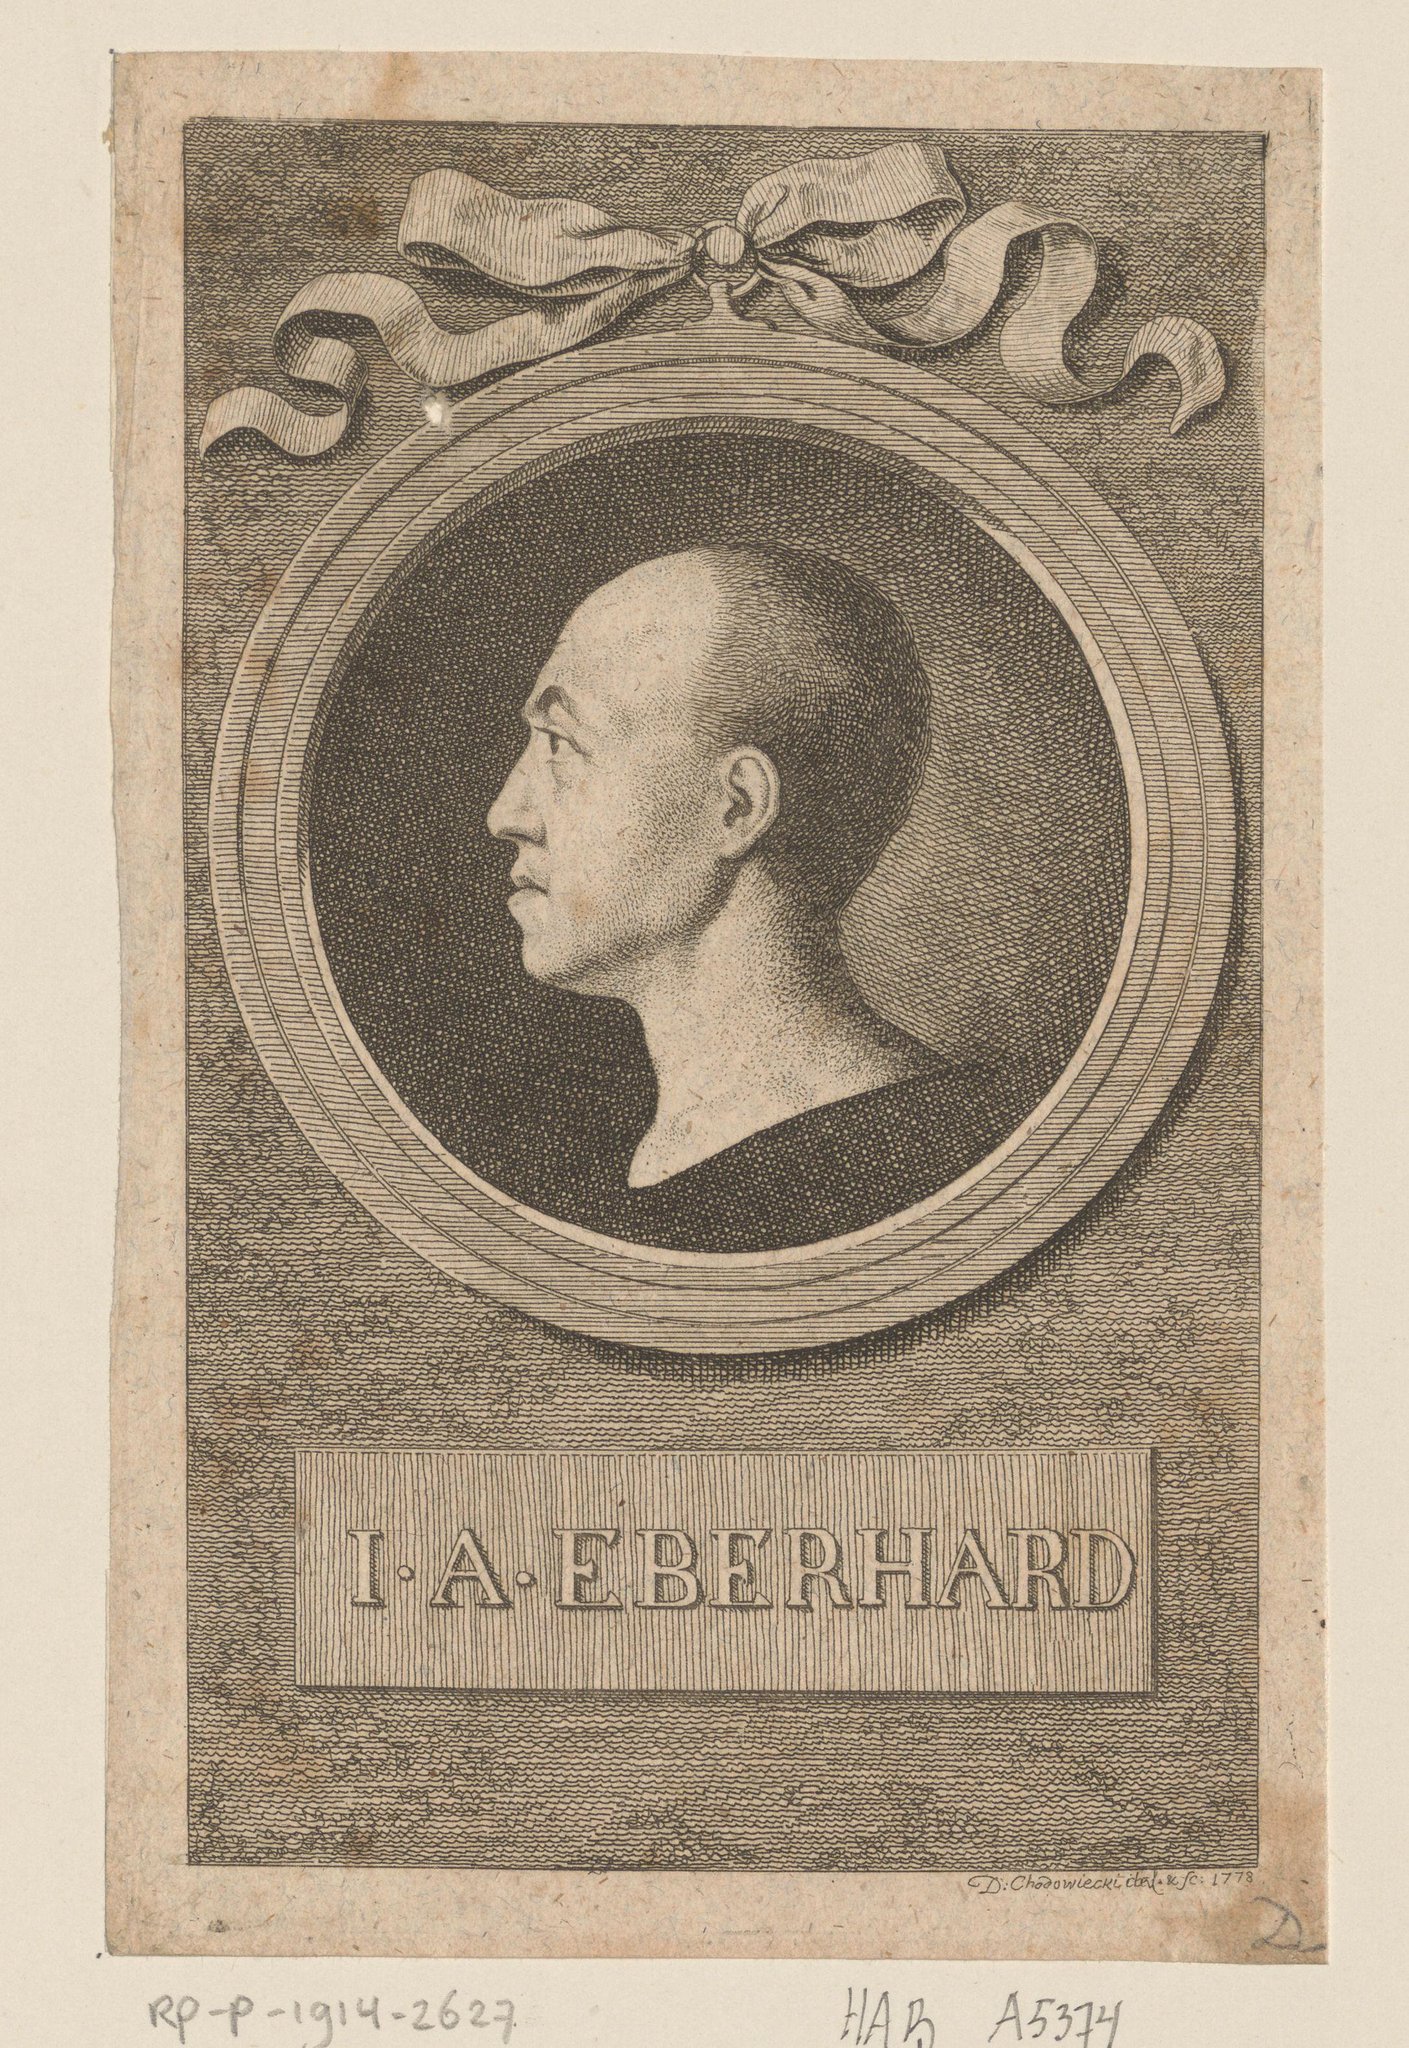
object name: print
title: Portret van Johann August Eberhard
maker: daniel nikolaus chodowiecki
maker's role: draughtsman, print maker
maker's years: 1726-1801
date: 1778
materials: paper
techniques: etching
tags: theologian, historical persons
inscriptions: collector's mark: Lugt 2228